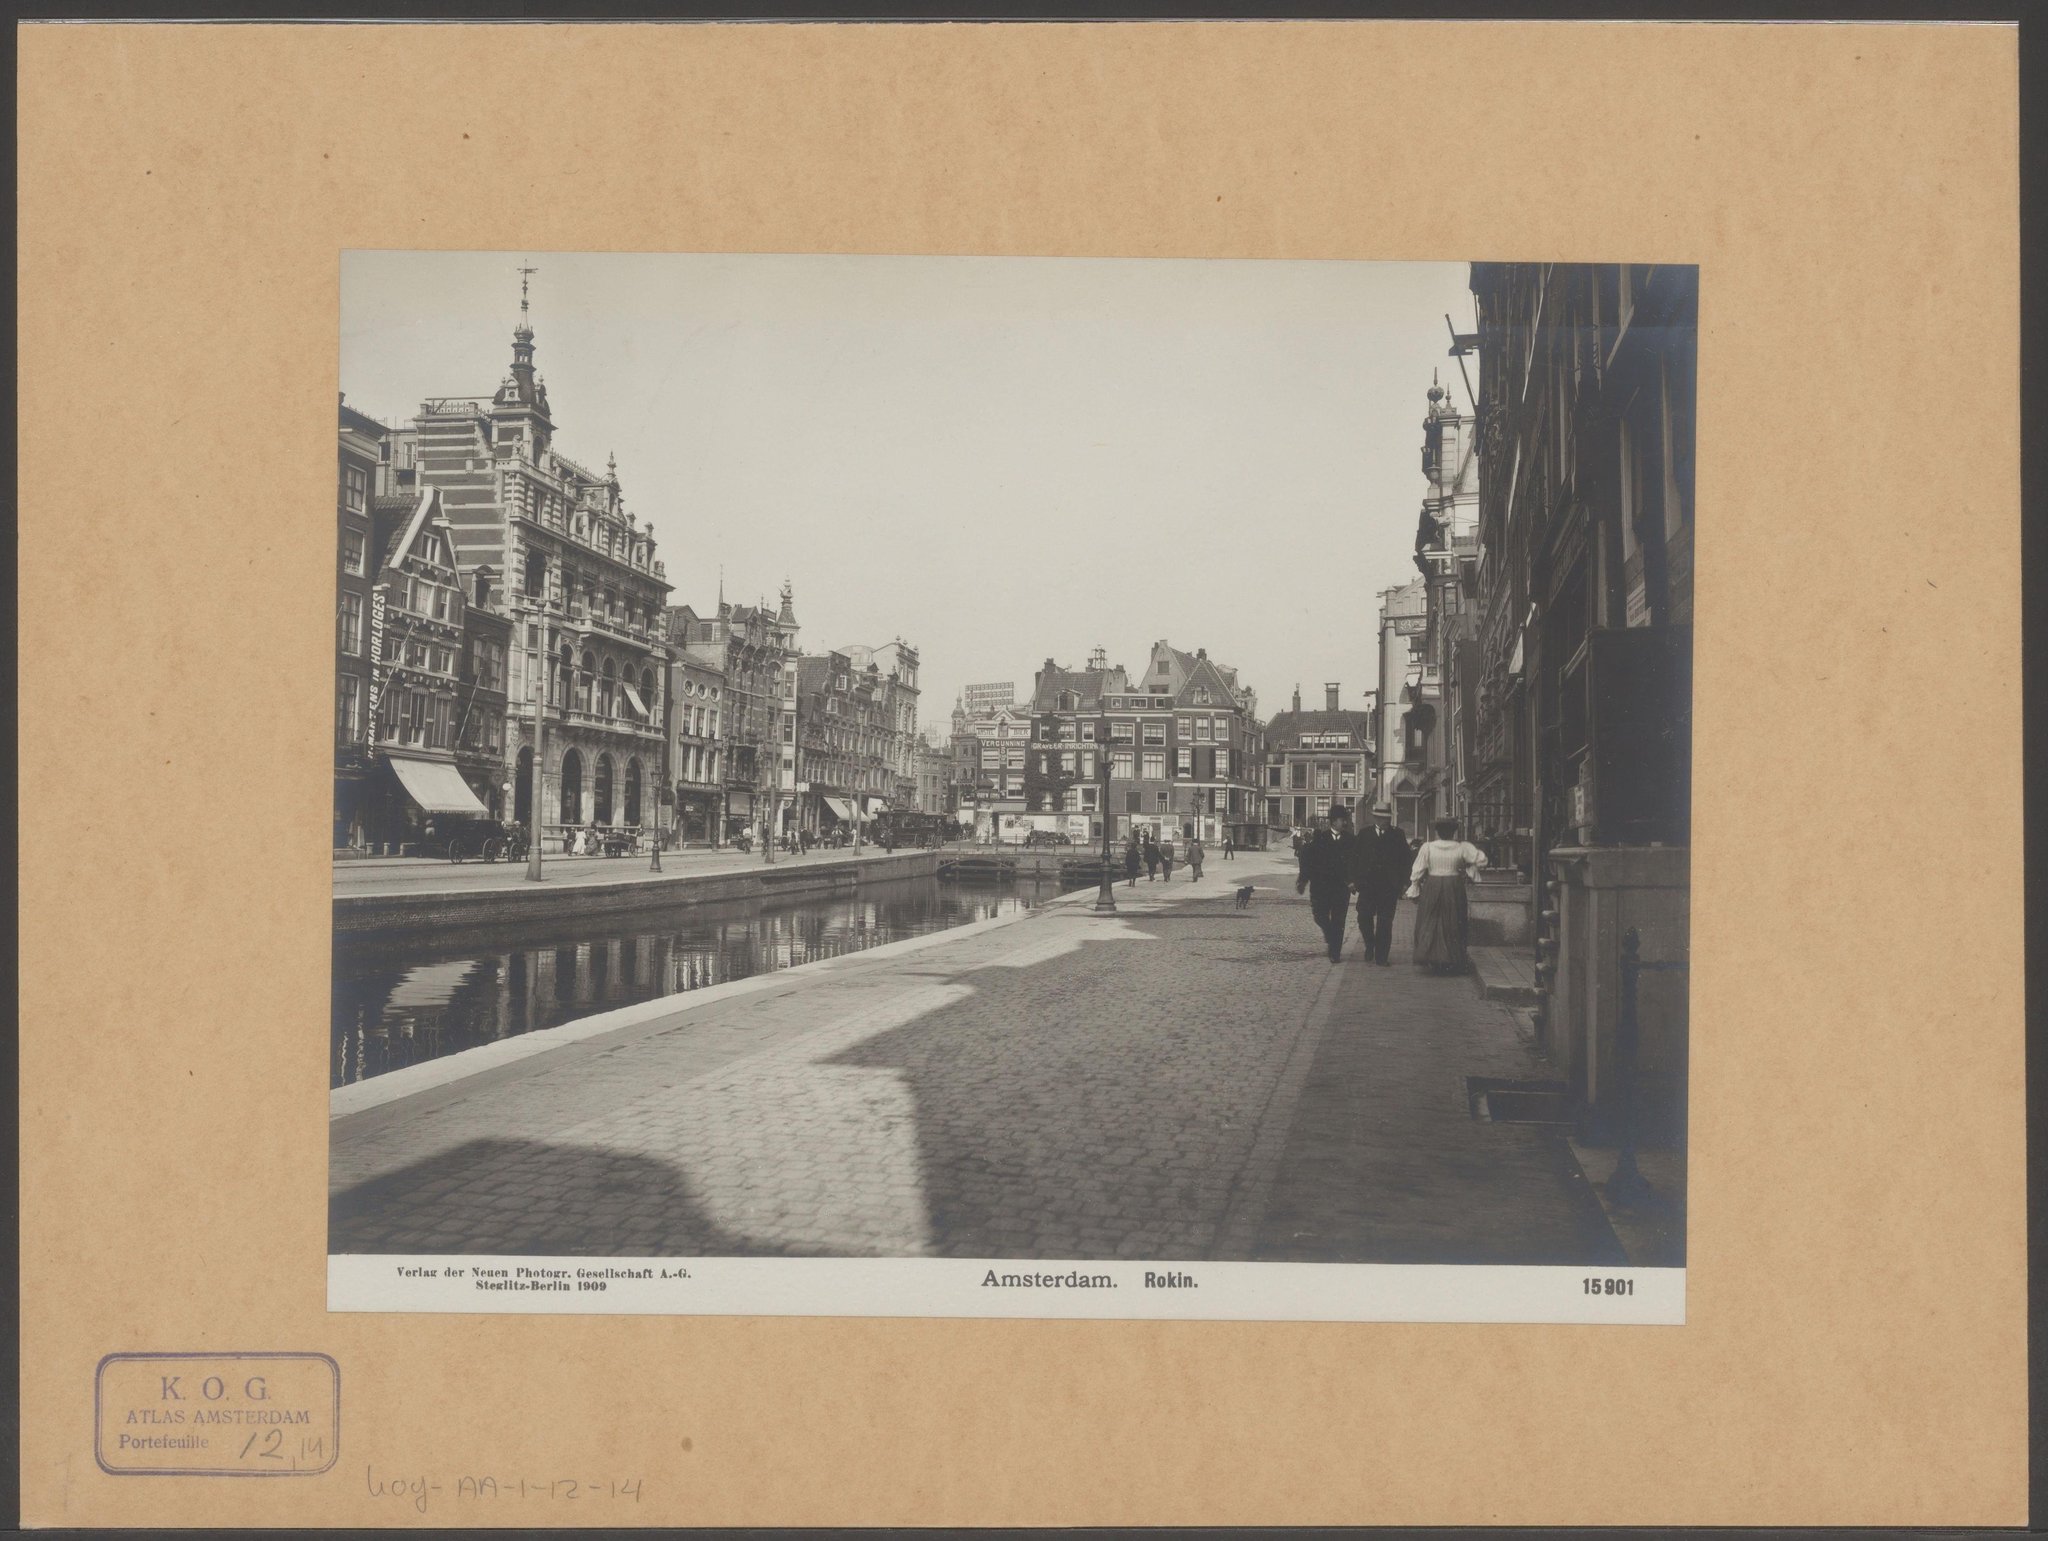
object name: photograph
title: Gezicht op het Rokin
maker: Anonymous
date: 1909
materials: paper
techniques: gelatin silver print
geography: germany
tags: city-view in general; 'veduta', canal, the usual house or row of houses, street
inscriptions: collector's mark: ‘12,14’ Lugt 1641b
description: Onderwerpsrubriek binnen de Atlas Amsterdam: Rokin, Rotterdammersloot, Rozengang, Rozengracht, Rozenstraat, Rusland, Rustenburgerstraat, Ruysdaelkade, Ruysdaelstraat, Ruyterkade (de), Ruyterweg (Admiraal de).